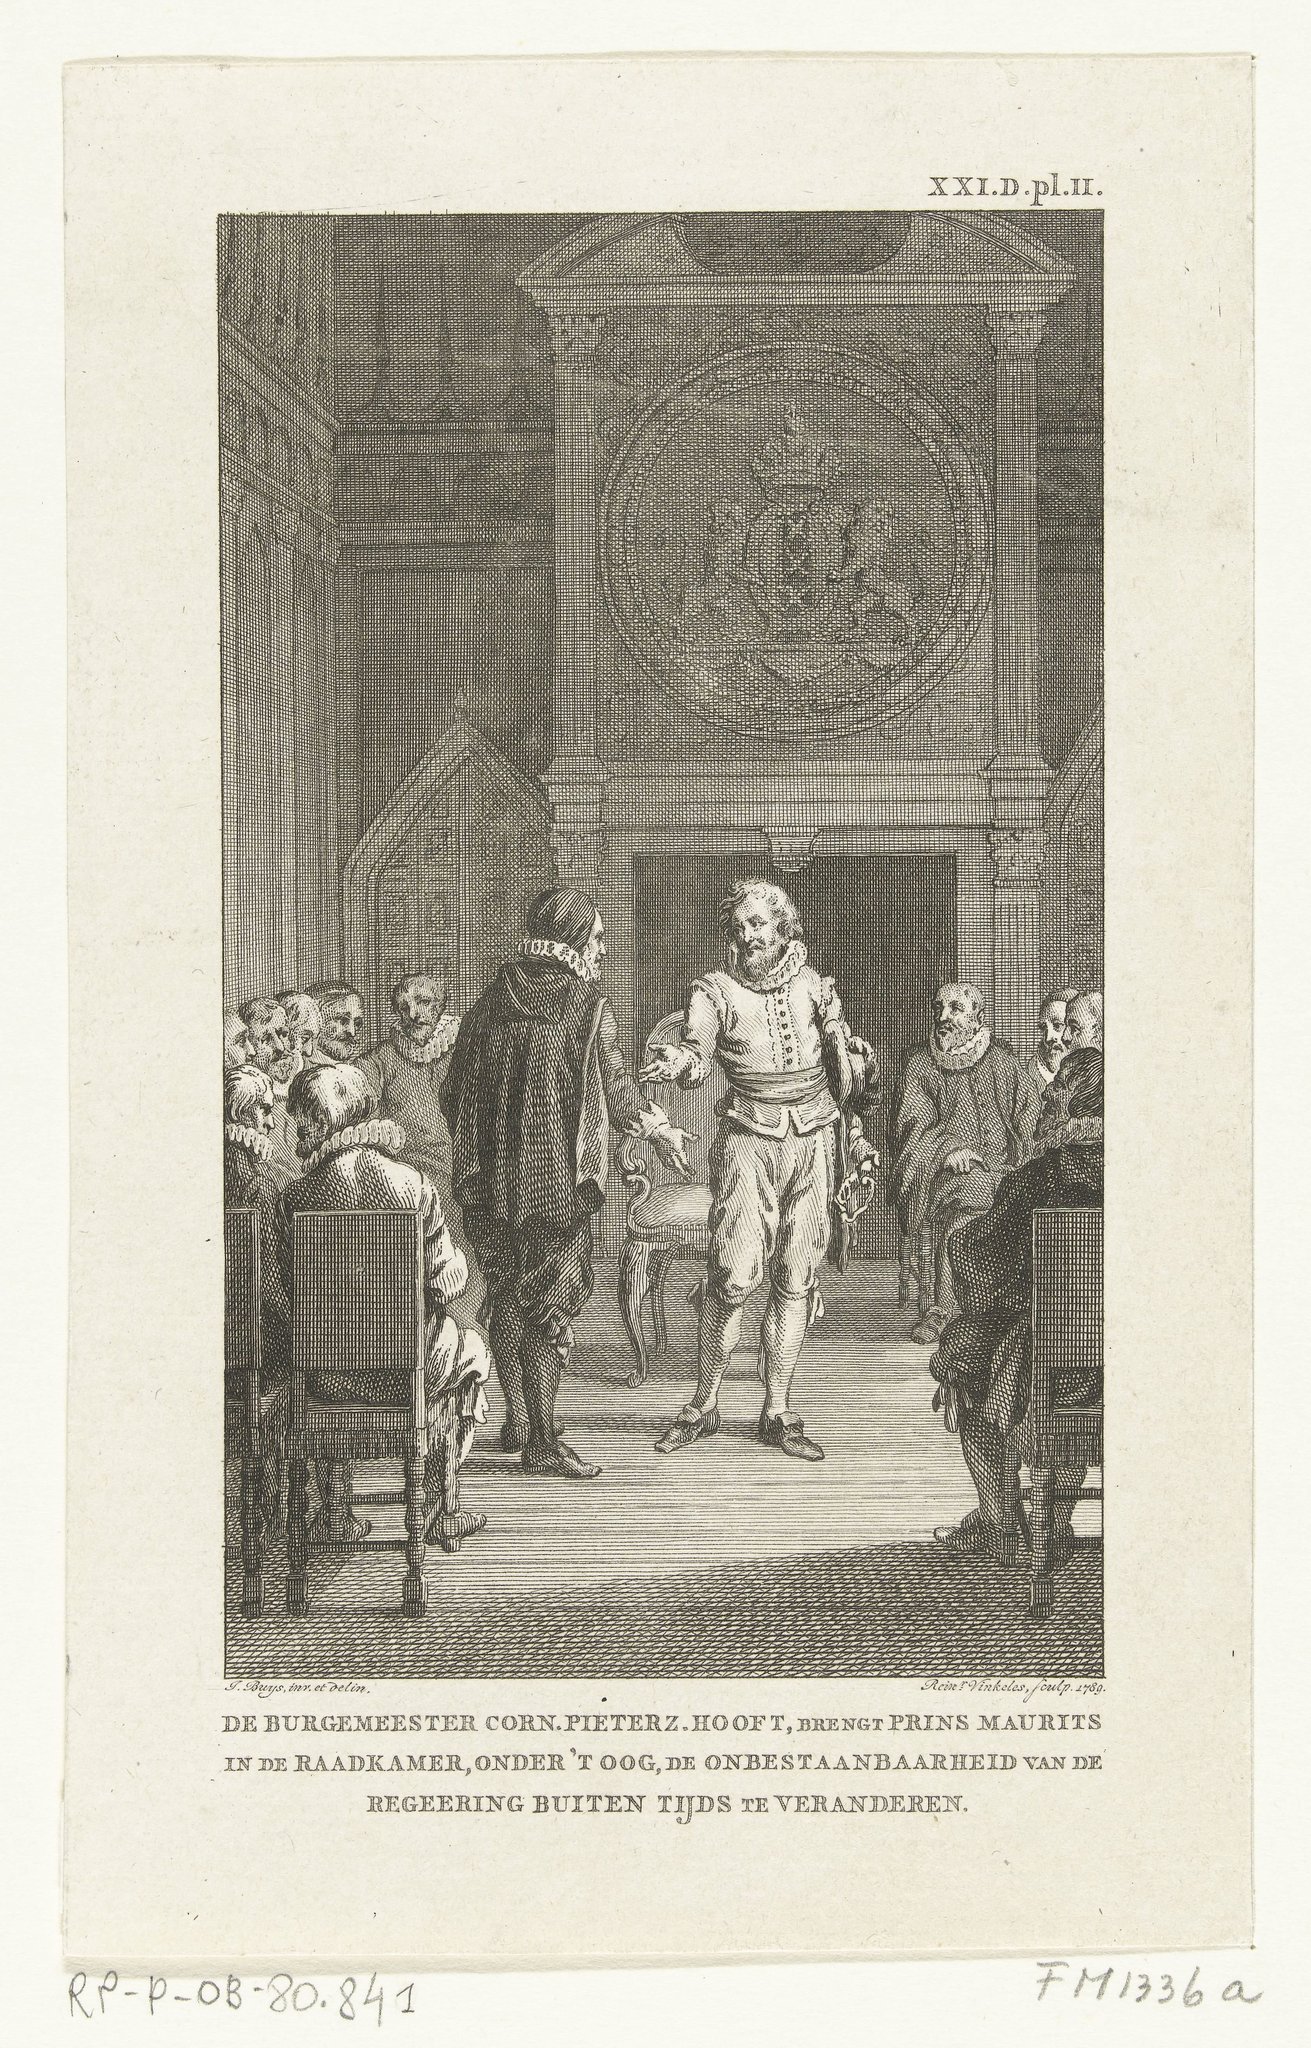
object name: history print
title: Burgemeester Cornelis Pietersz. Hooft pleit bij Maurits tegen het verzetten van de wet te Amsterdam, 1618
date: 1789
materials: paper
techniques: etching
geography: netherlands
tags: maurice (prince of orange), mayor, cornelis pietersz. hooft, amsterdam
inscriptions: date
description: Burgemeester Cornelis Pietersz. Hooft pleit bij Maurits tegen het verzetten van de wet te Amsterdam, 3 november 1618. Interieur met Maurits en Hooft staande tegenover elkaar in de raadskamer van het stadhuis te Amsterdam.